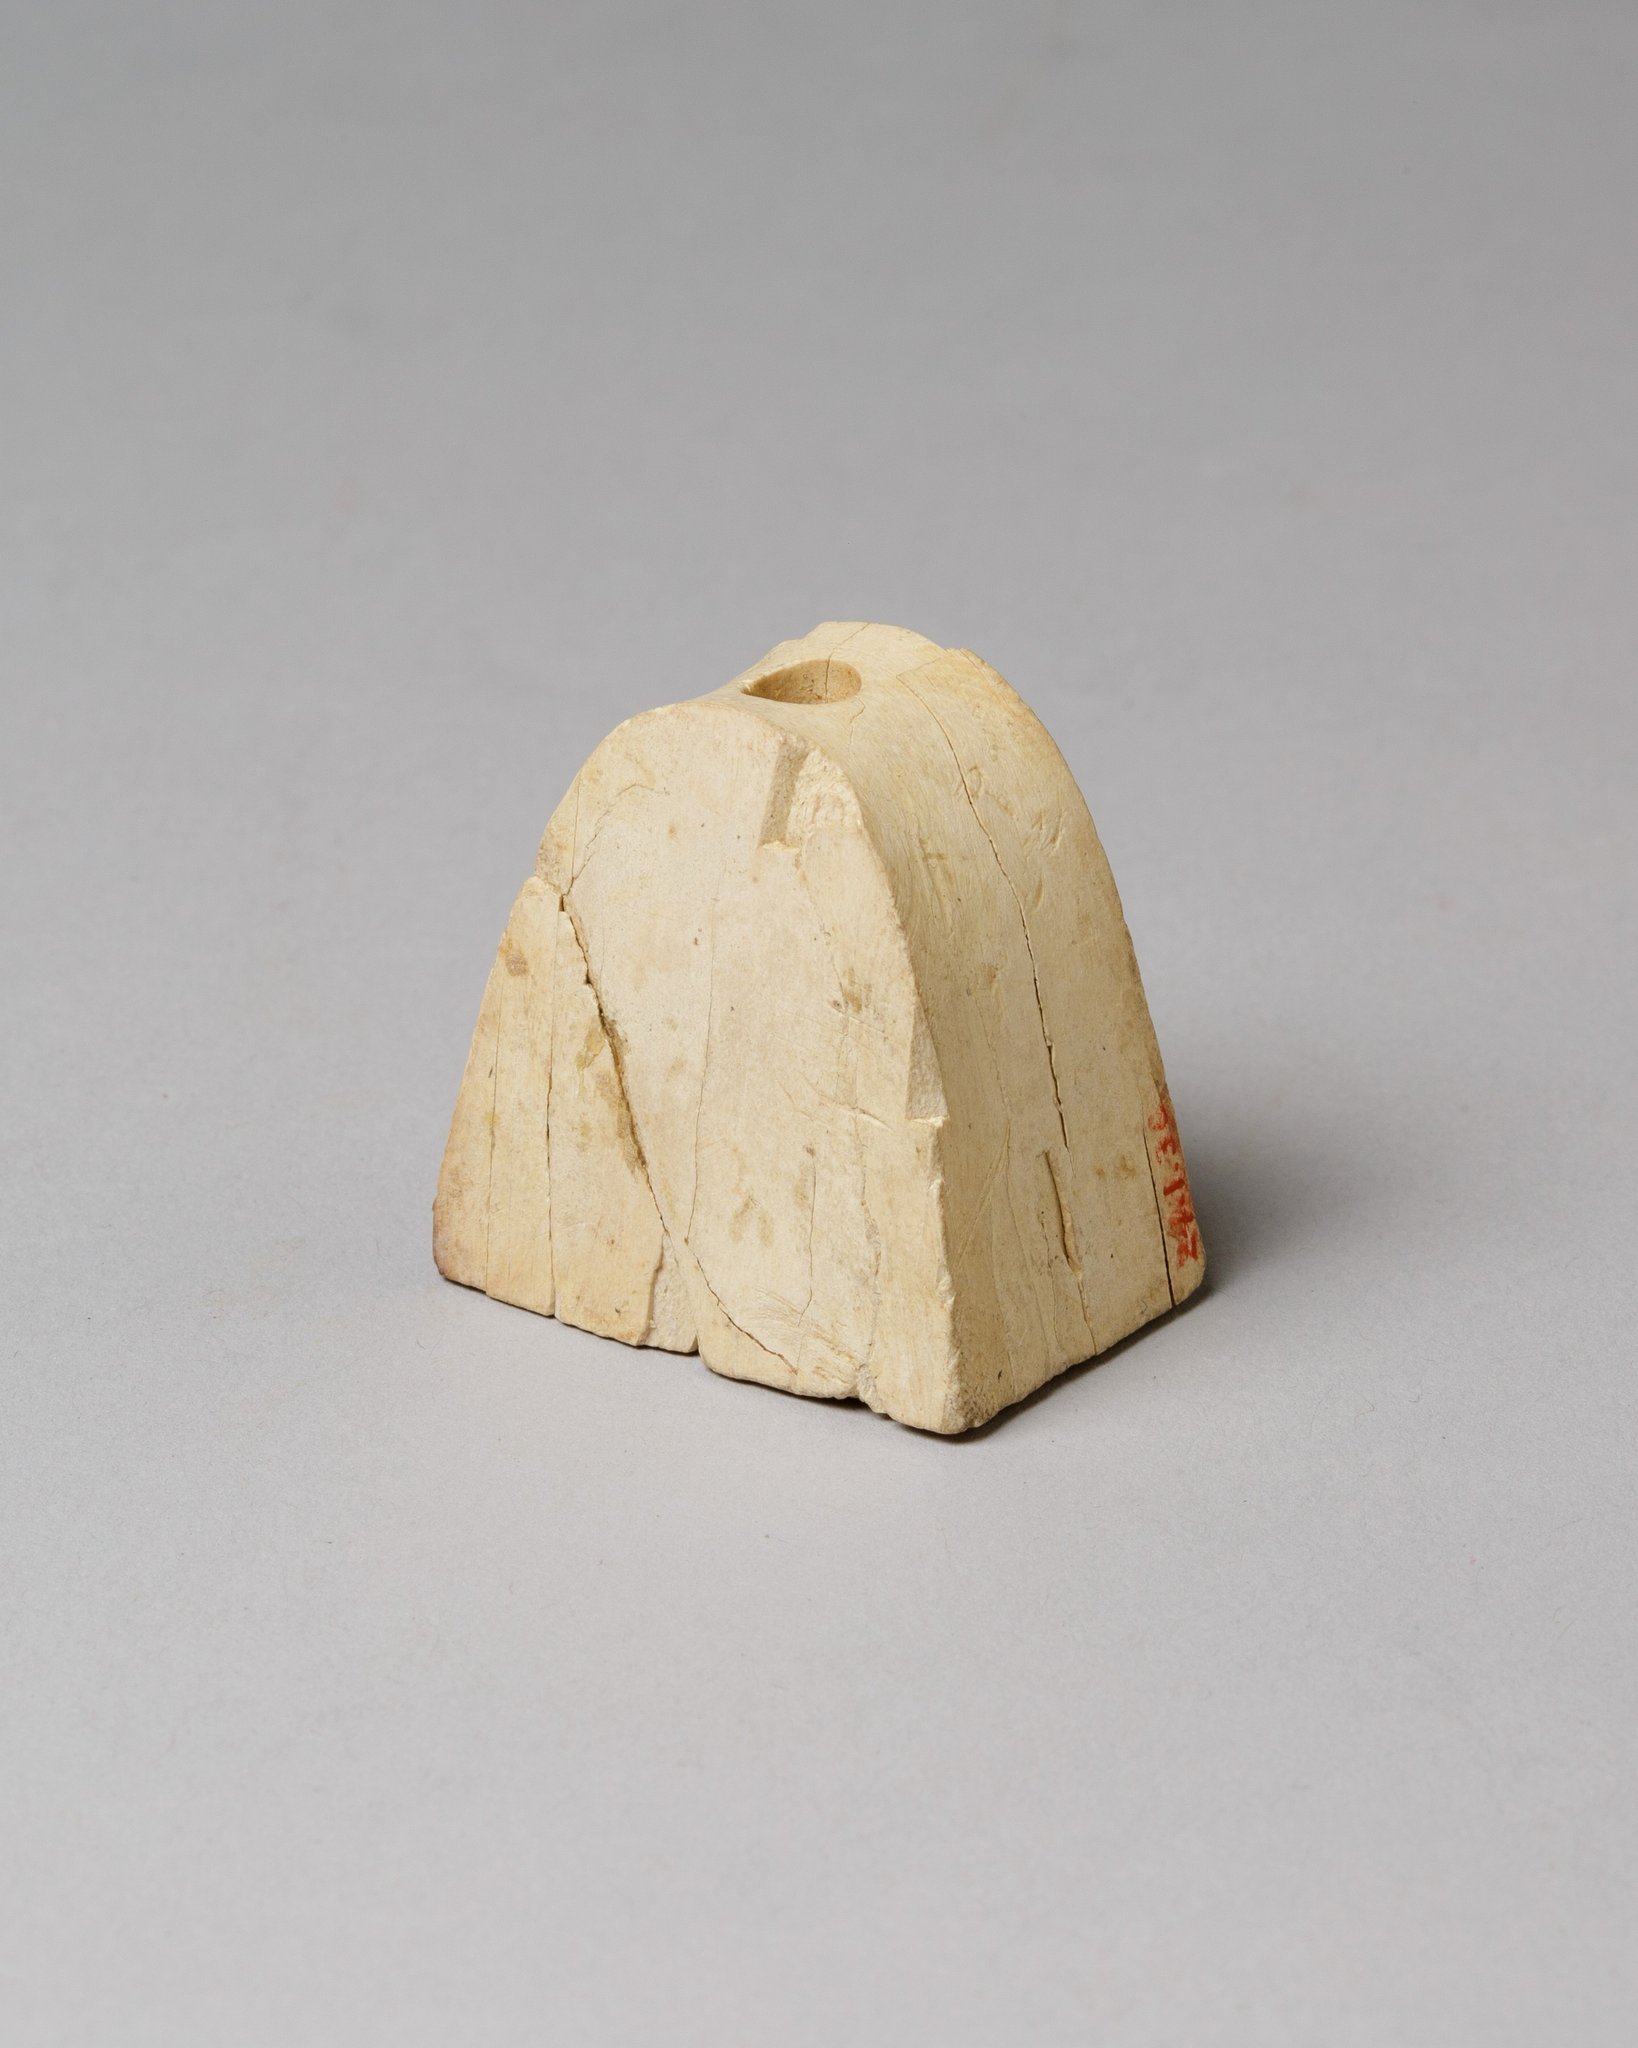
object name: papyrus burnisher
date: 1981-1802 BCE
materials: ivory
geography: egypt